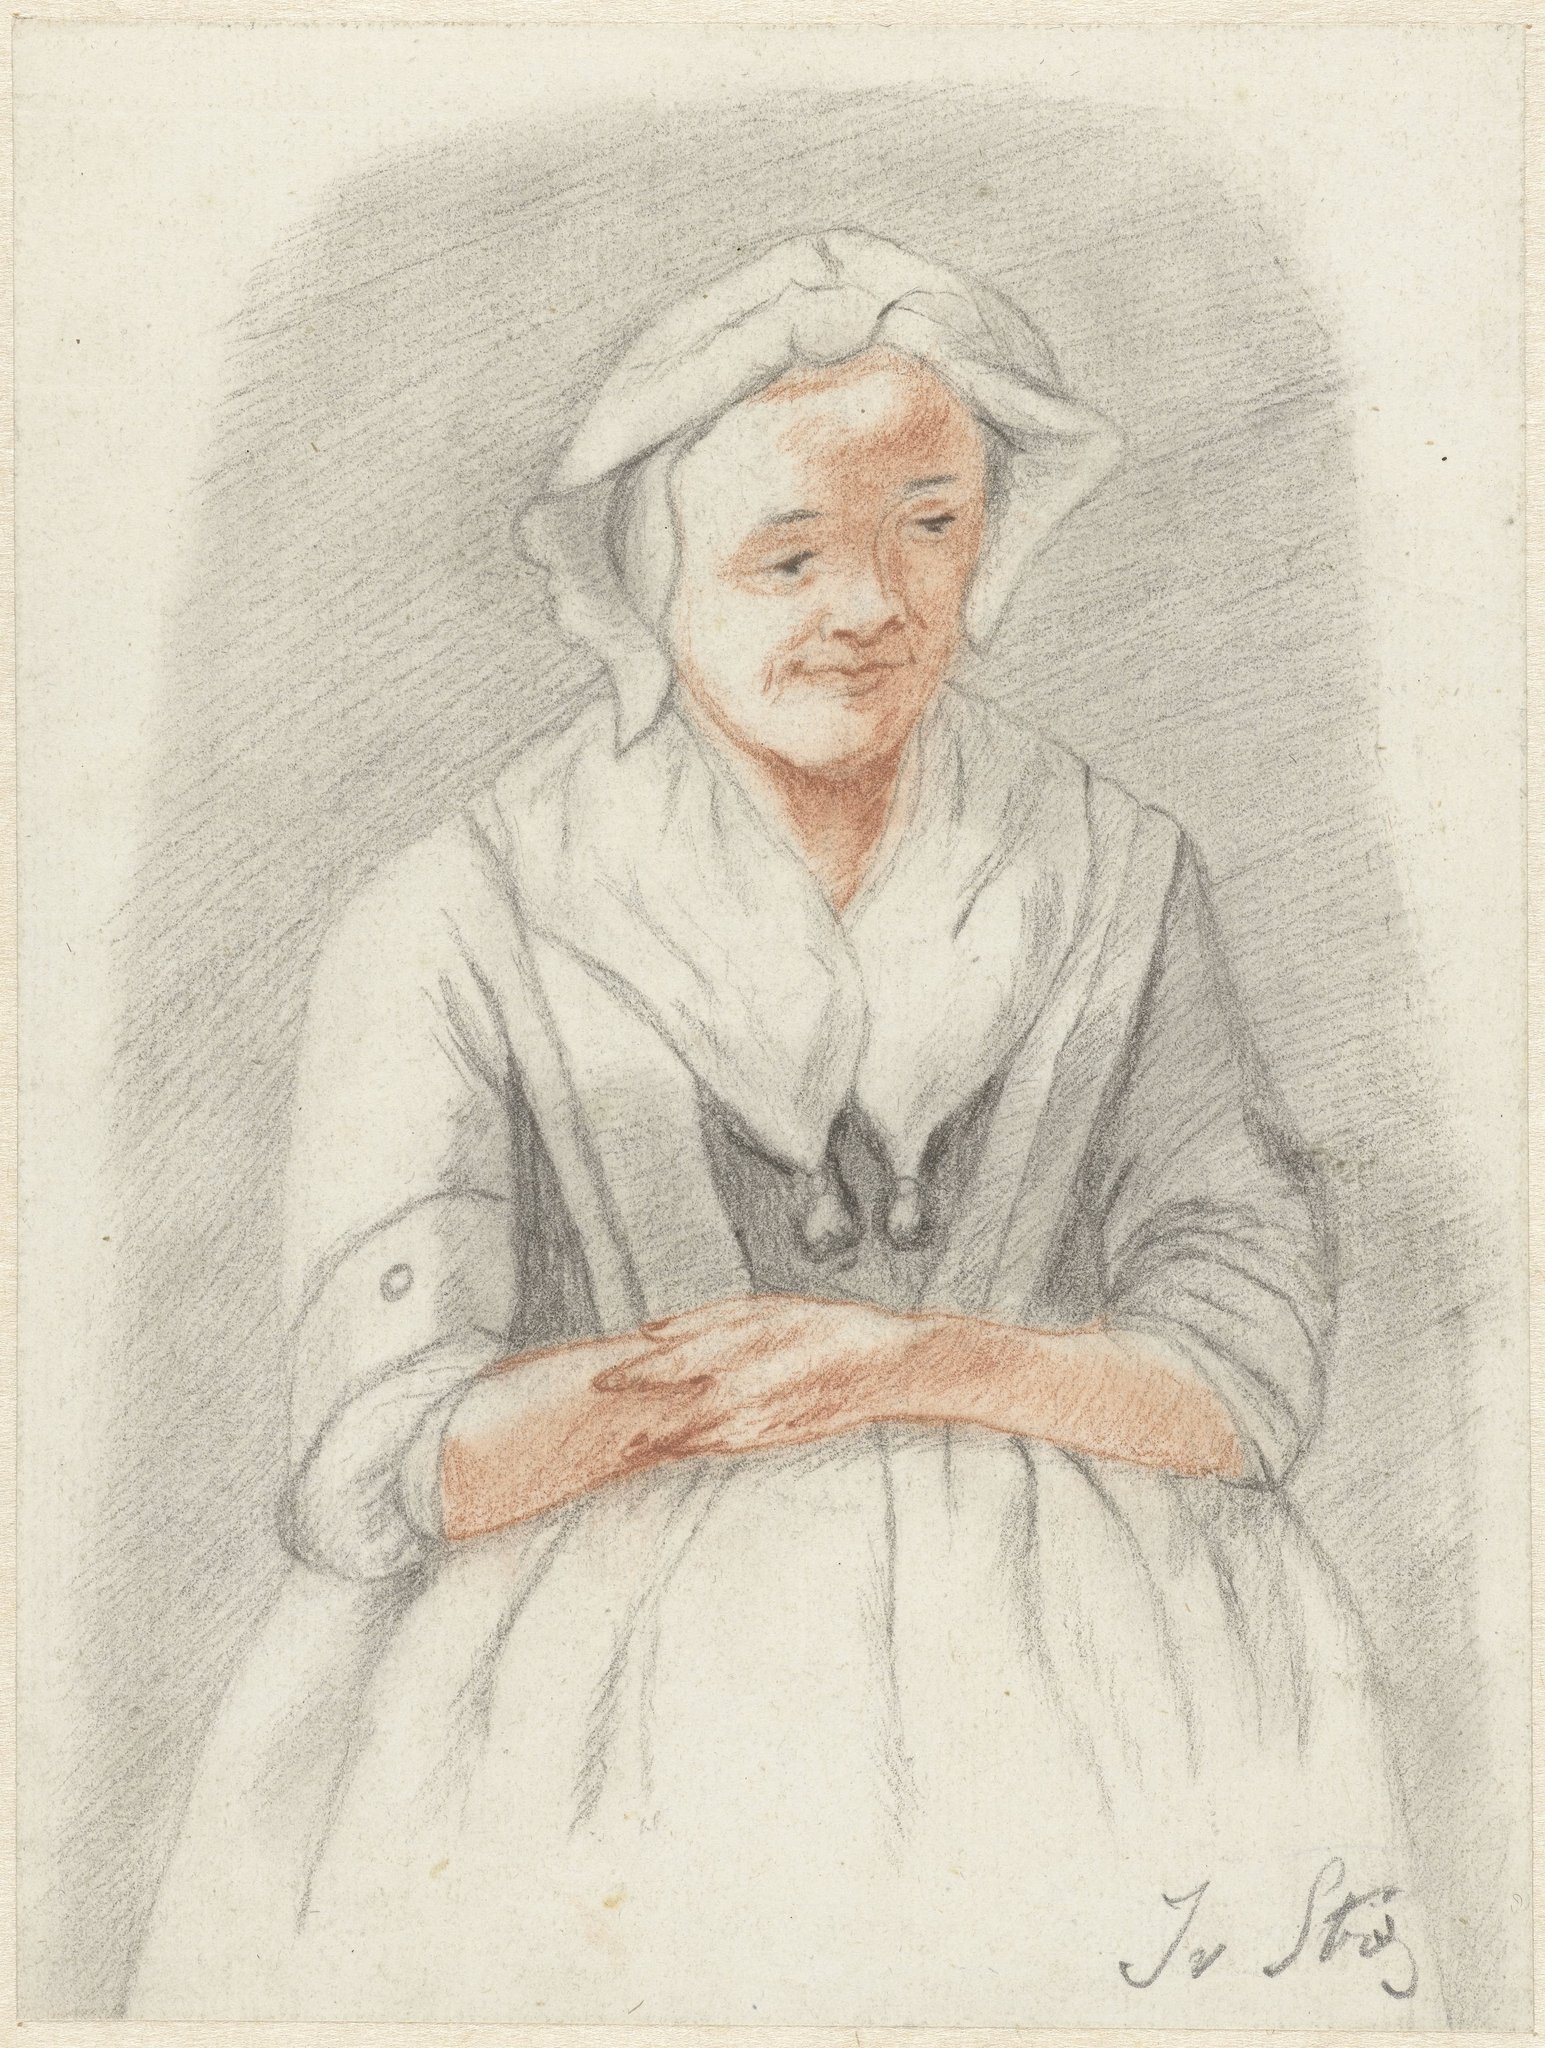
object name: drawing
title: De dienstmaagd bij het huwelijksaanzoek van Reinier Adriaansz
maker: jacob van strij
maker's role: draughtsman, painter, print maker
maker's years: 1756-1815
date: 1766-1815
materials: chalk, paper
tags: (scenes from) specific works of literature (with author, title), comedy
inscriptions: signature: ‘J v Stry’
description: Kopie naar een schilderij van Cornelis Troost: Jan Claasz of de Gewaande dienstmaagd; 1e bedrijf 6de toneel, Tjerk Heindrikze en Stoffel Thyssen komen bij Jan Jasperse en zijn vrouw Diwertje om de hand van hun dochter te vragen voor Reinier Adriaansz.